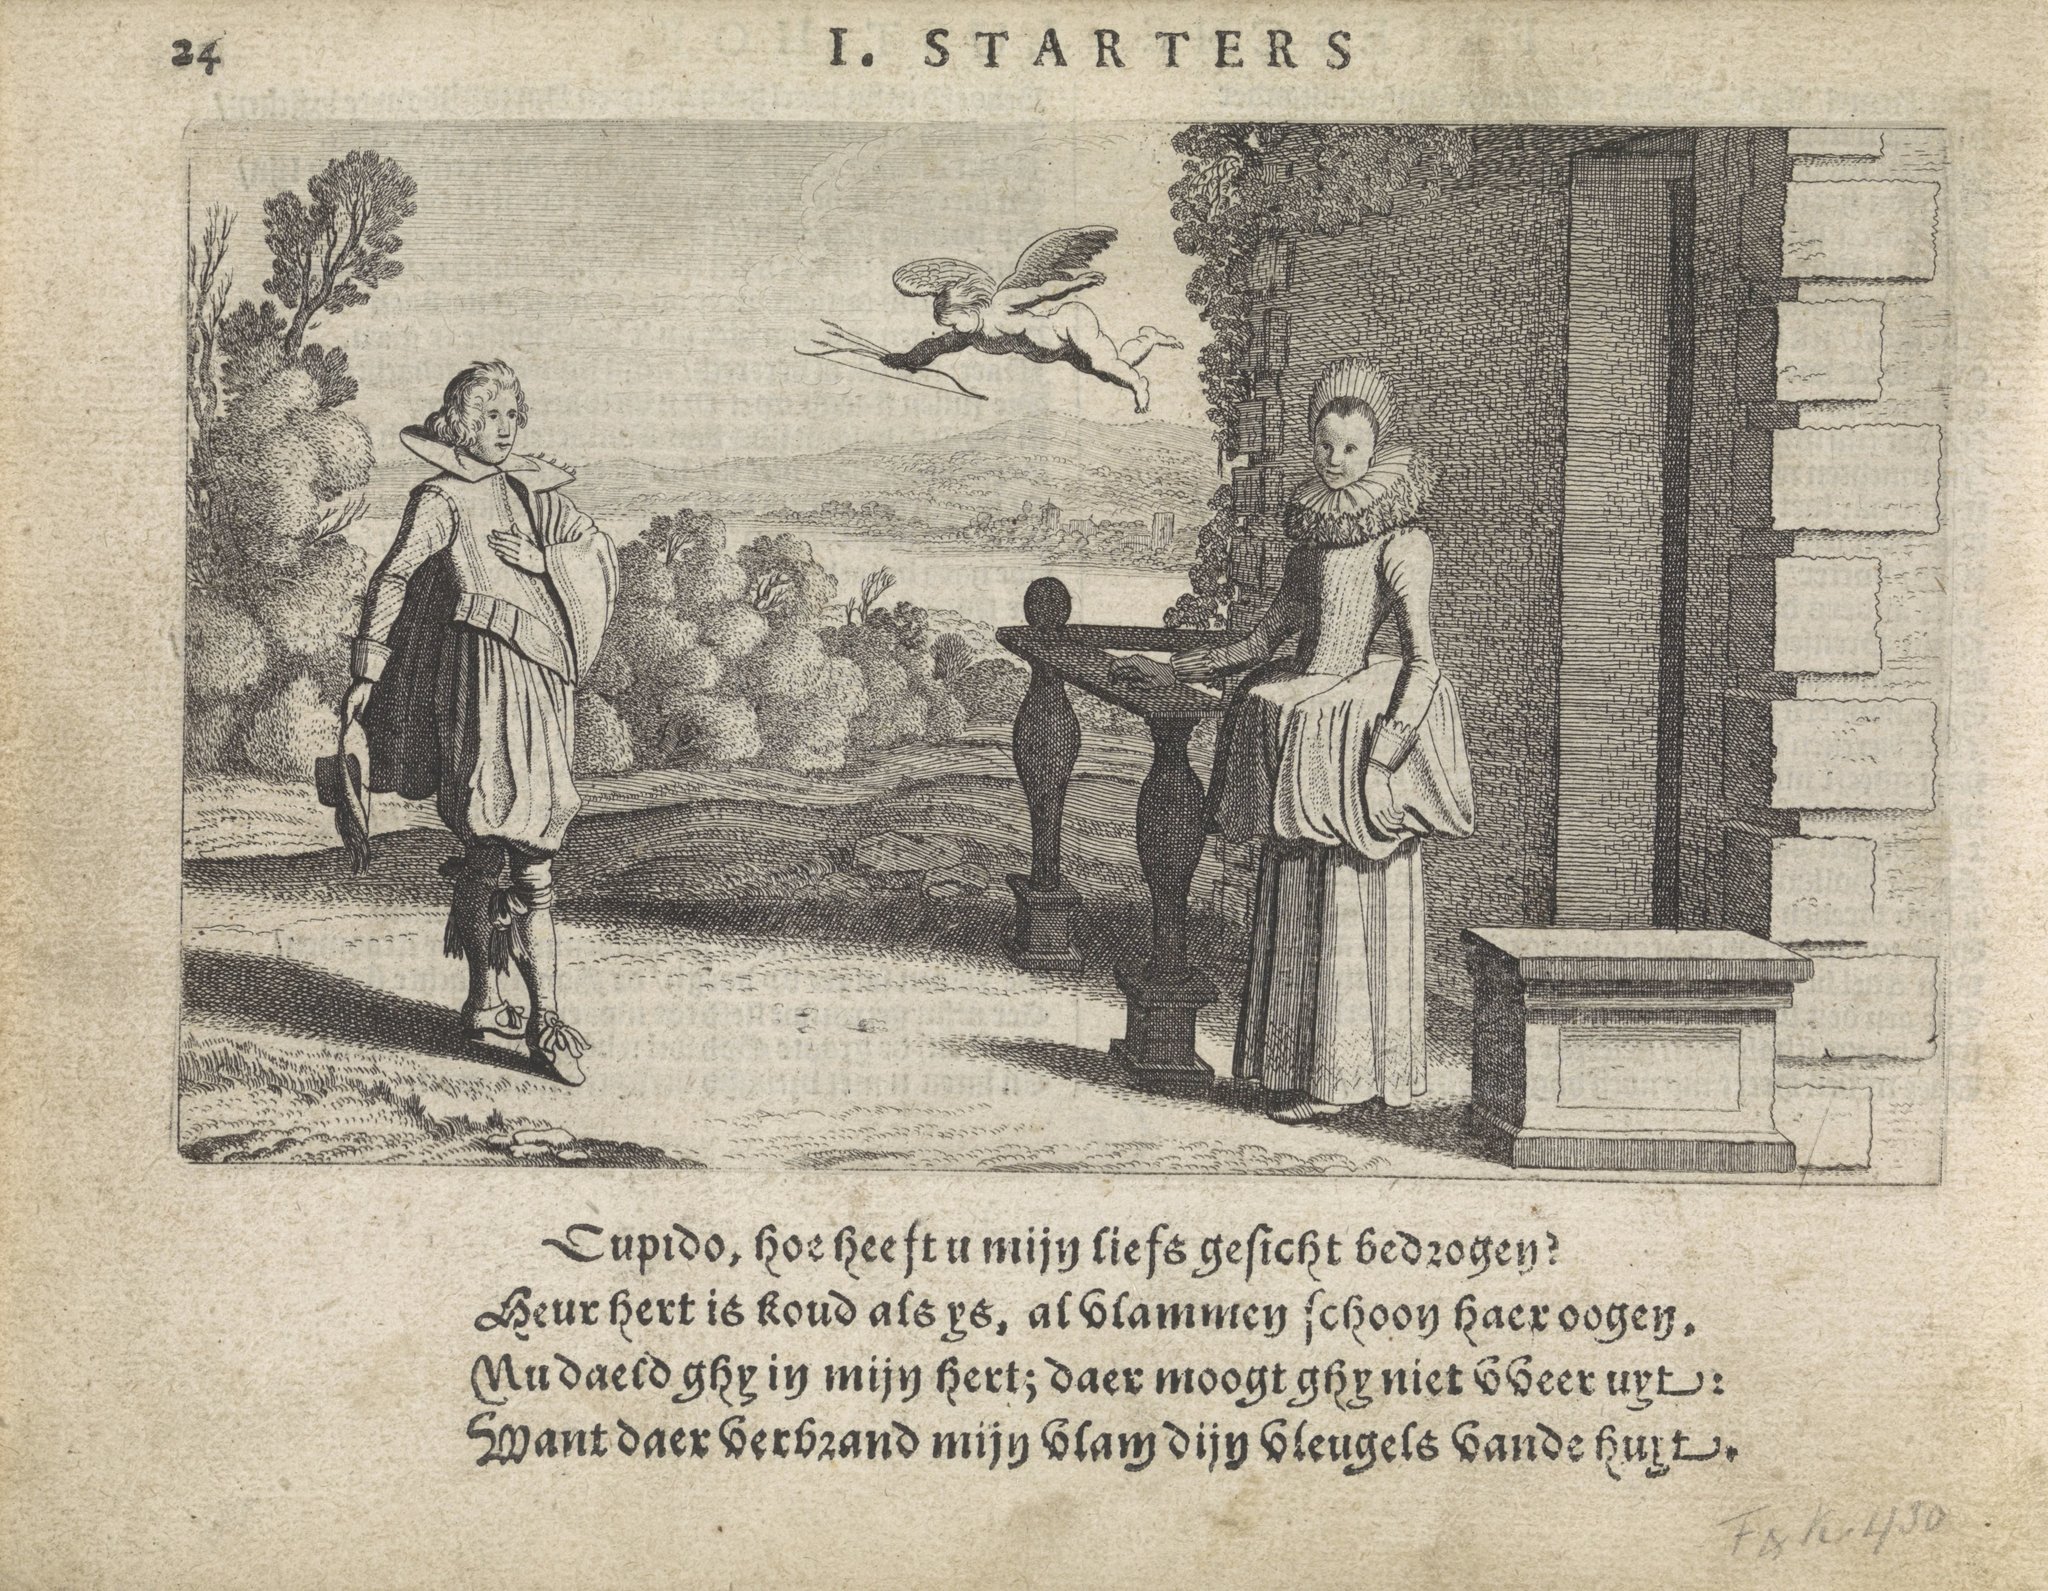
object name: book illustration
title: Man bij een jonge vrouw voor een huis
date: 1621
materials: paper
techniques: etching, letterpress printing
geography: amsterdam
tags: arm or hand held in front of the chest, balustrade, (story of) cupid, amor (eros), amorousness, desire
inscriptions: collector's mark: Lugt 964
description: Boekillustratie in: Starter, Jan Jansz. Friesche lust-hof, beplant met verscheyde stichtelyke minne-liedekens, gedichten, ende boertige kluchten. Amsterdam: Dirck Pietersz Voscuyl, 1621.